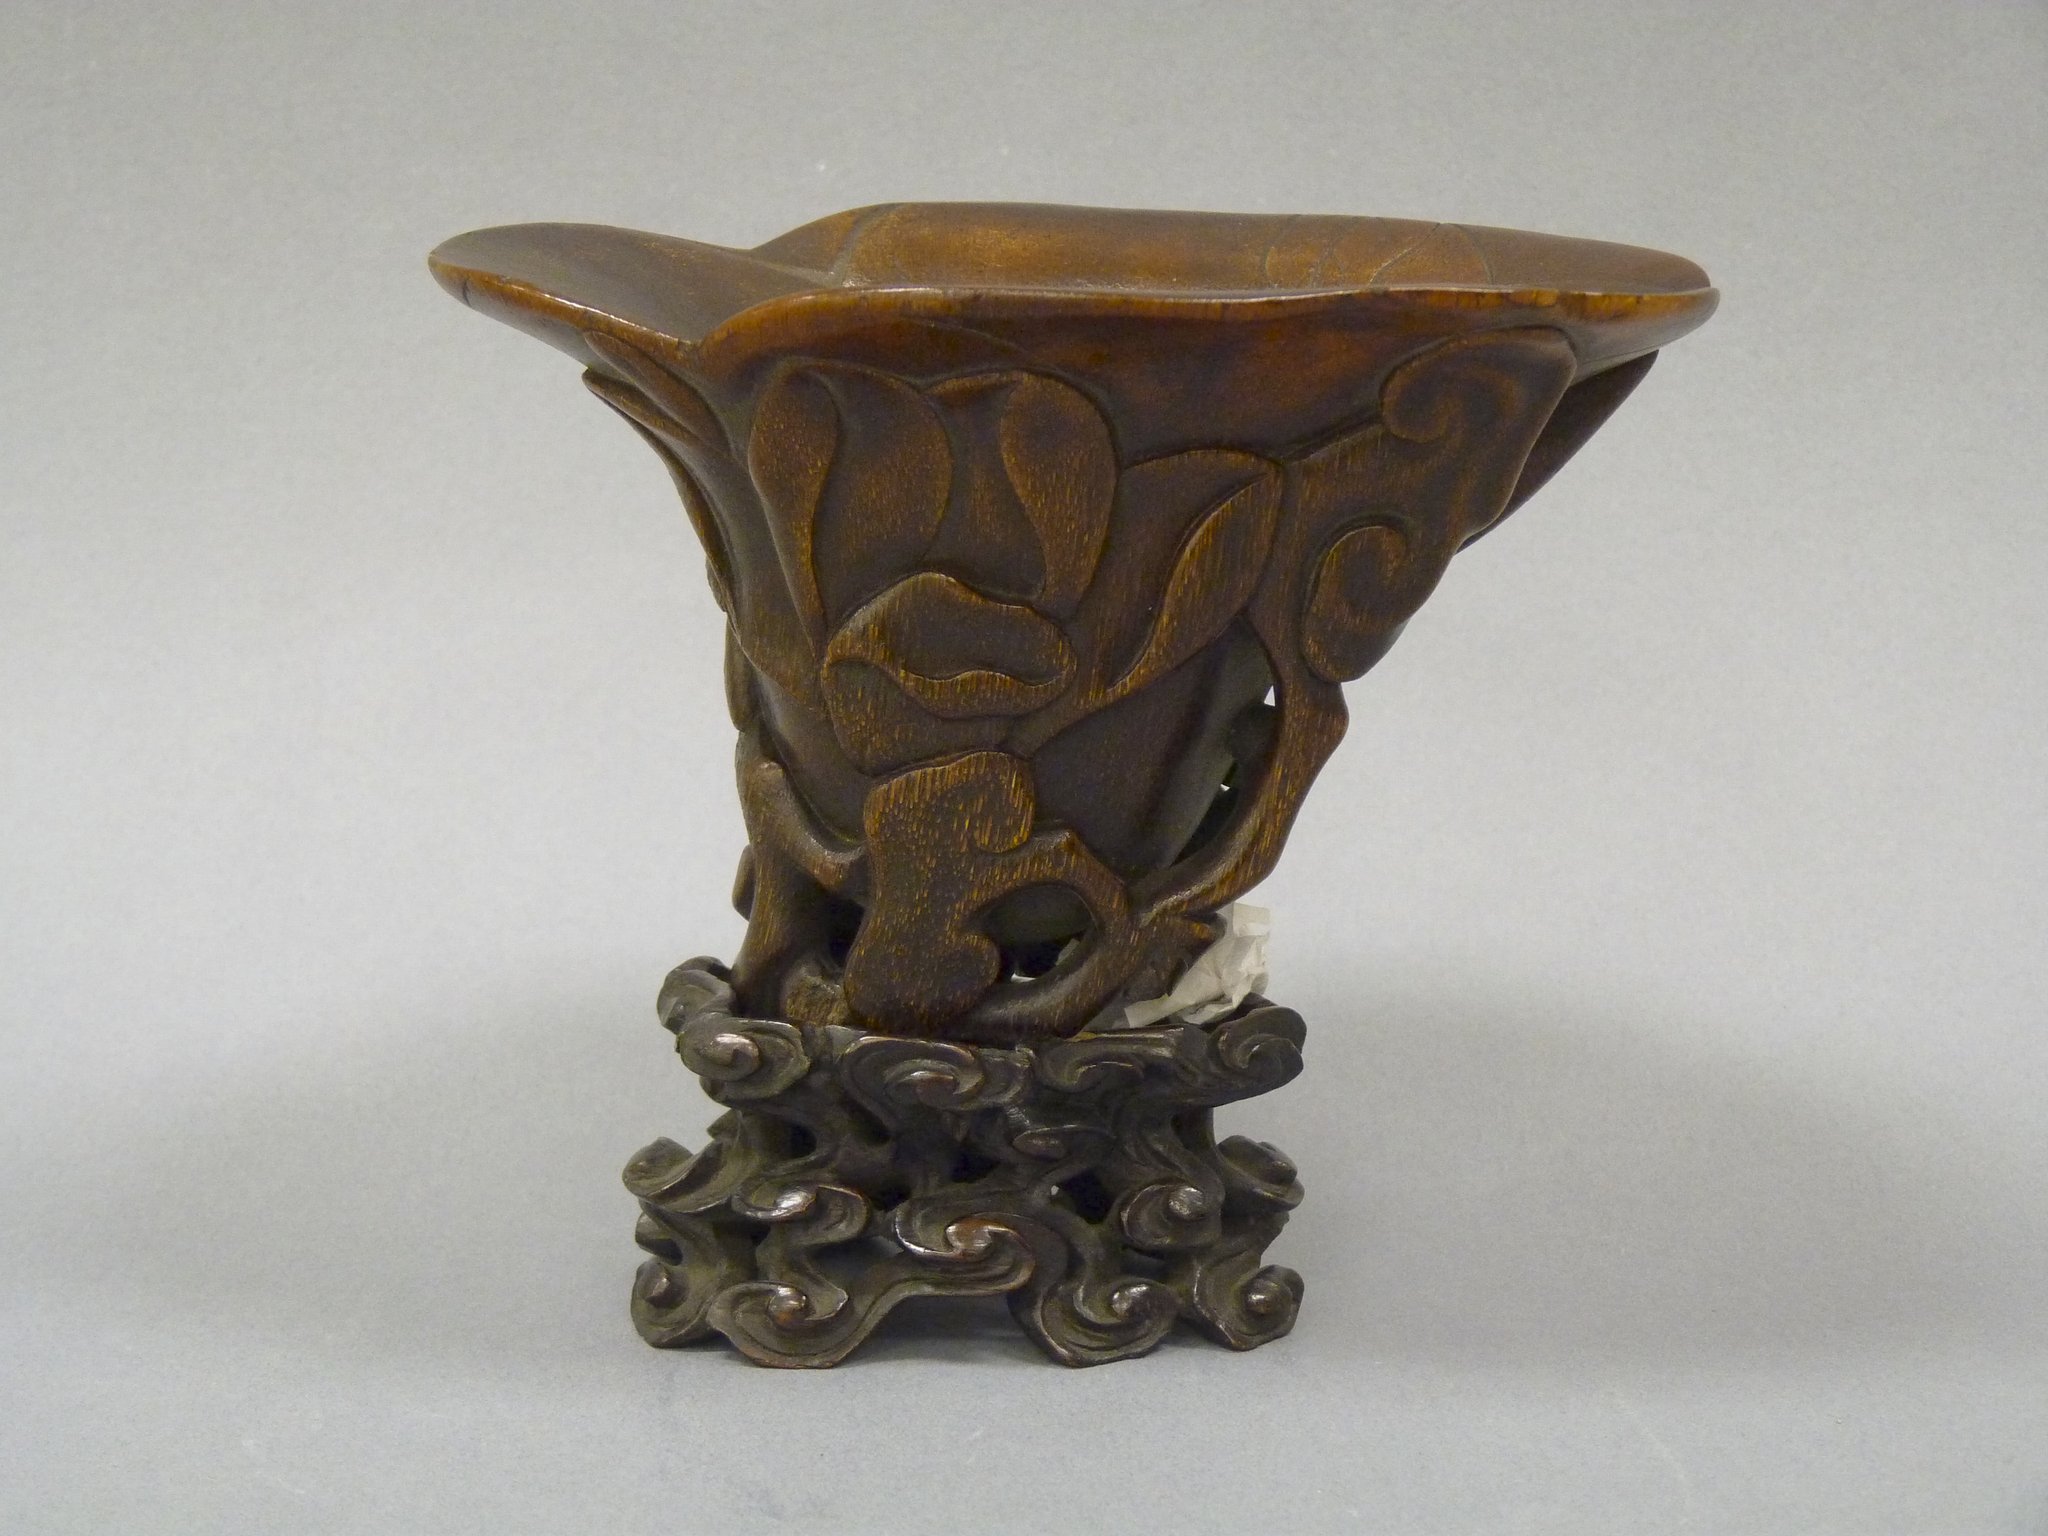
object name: cup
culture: chinese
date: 1701-1800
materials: horn